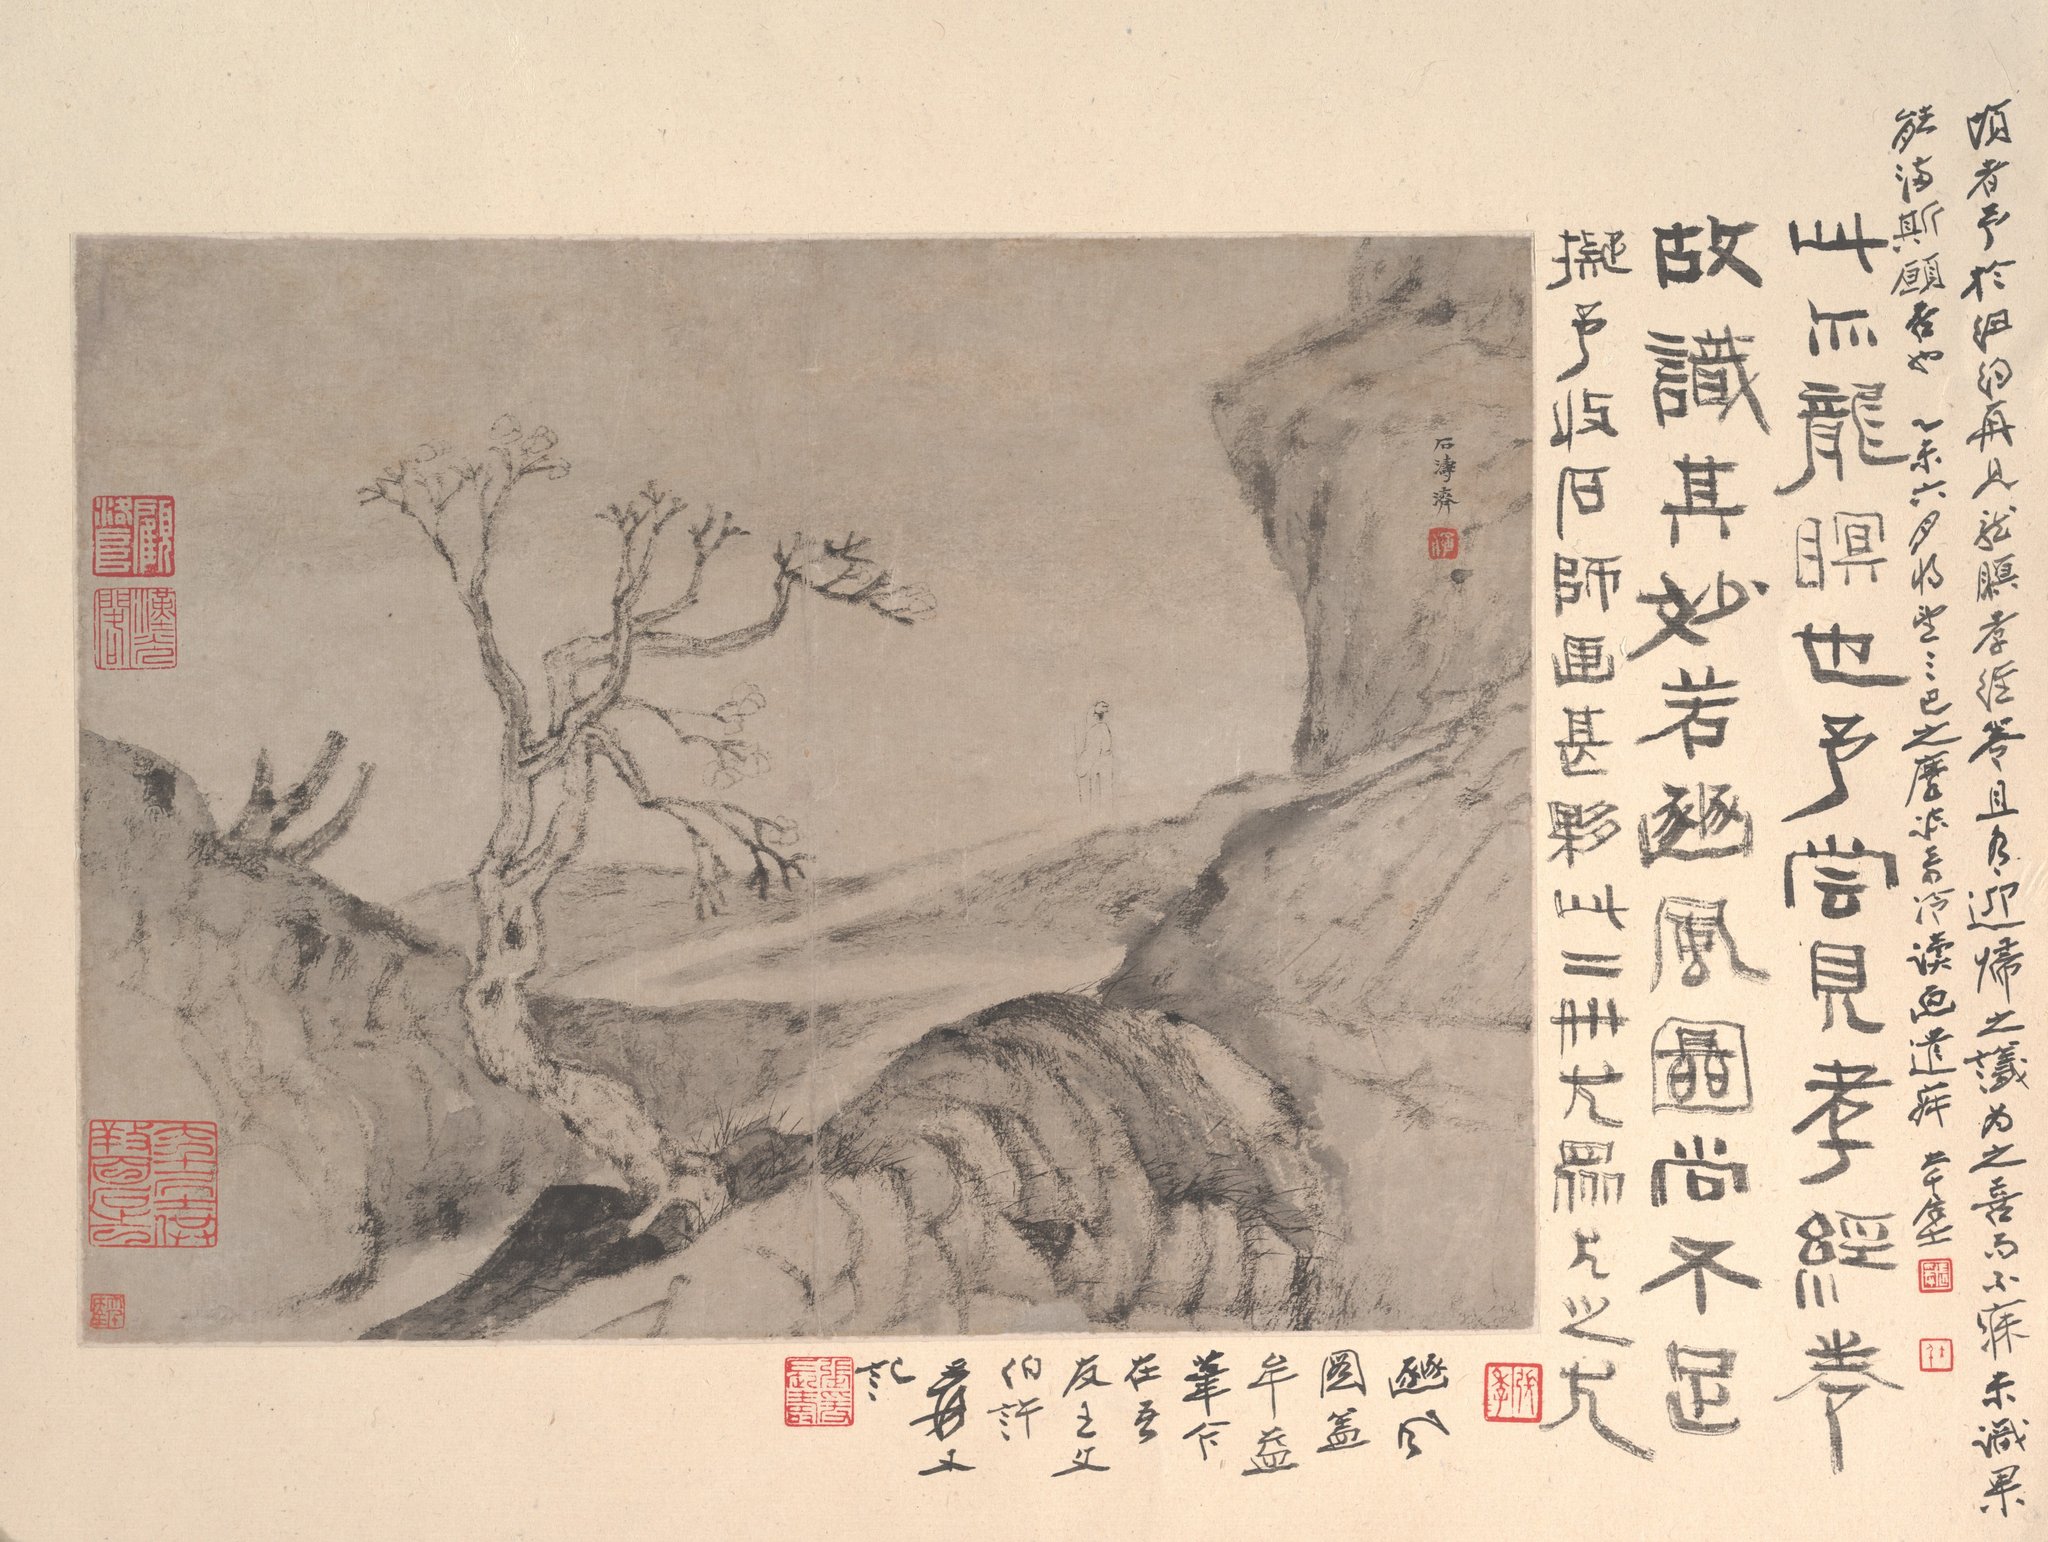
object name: album leaf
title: Landscape with solitary figure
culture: chinese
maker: shitao (zhu ruoji)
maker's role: artist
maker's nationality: chinese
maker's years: 1642-1707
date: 1660-1669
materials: ink, paper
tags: landscapes